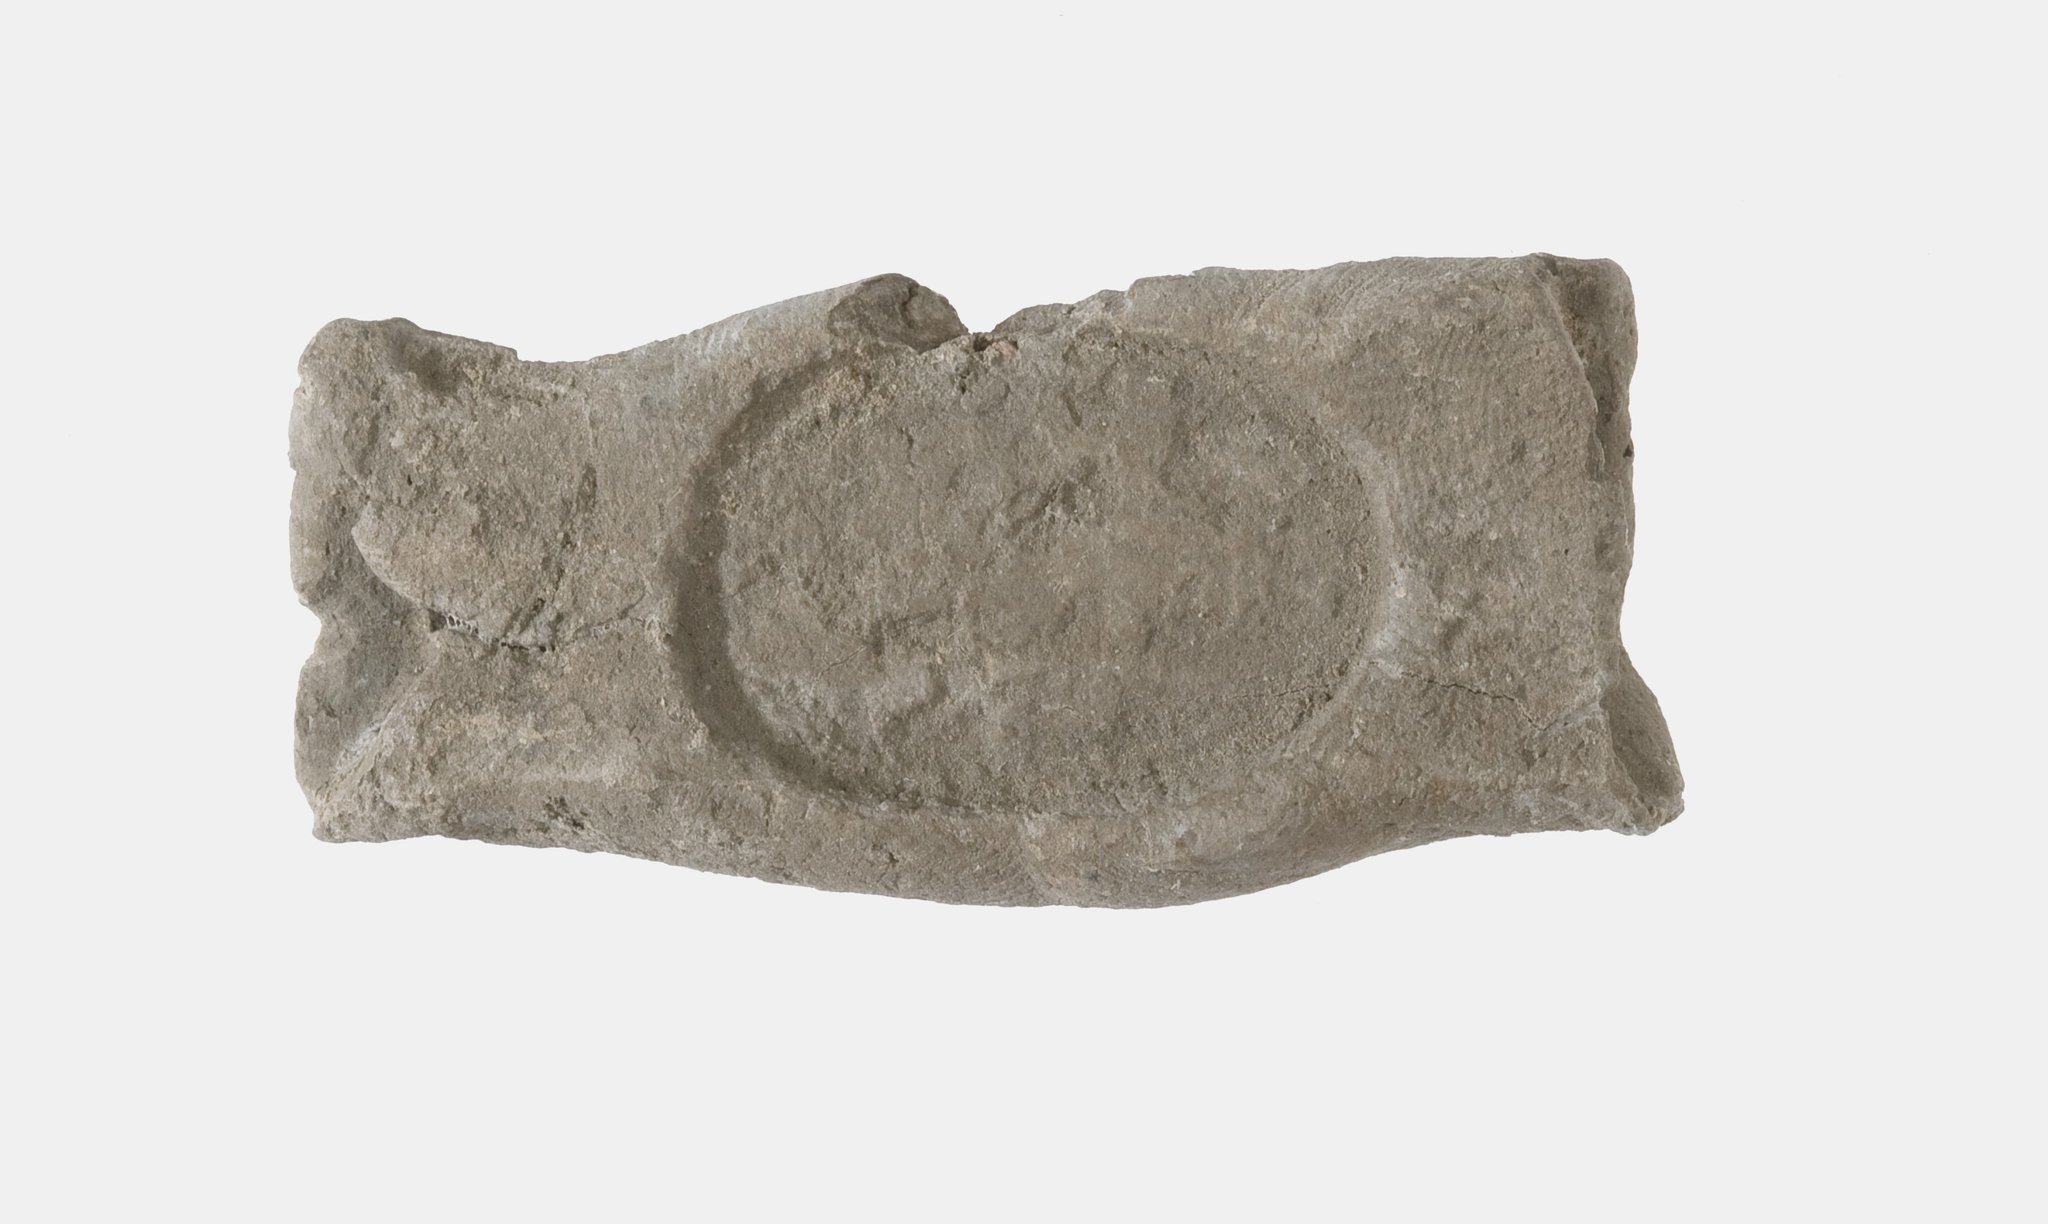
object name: sealing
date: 1850-1700 BCE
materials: mud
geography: egypt